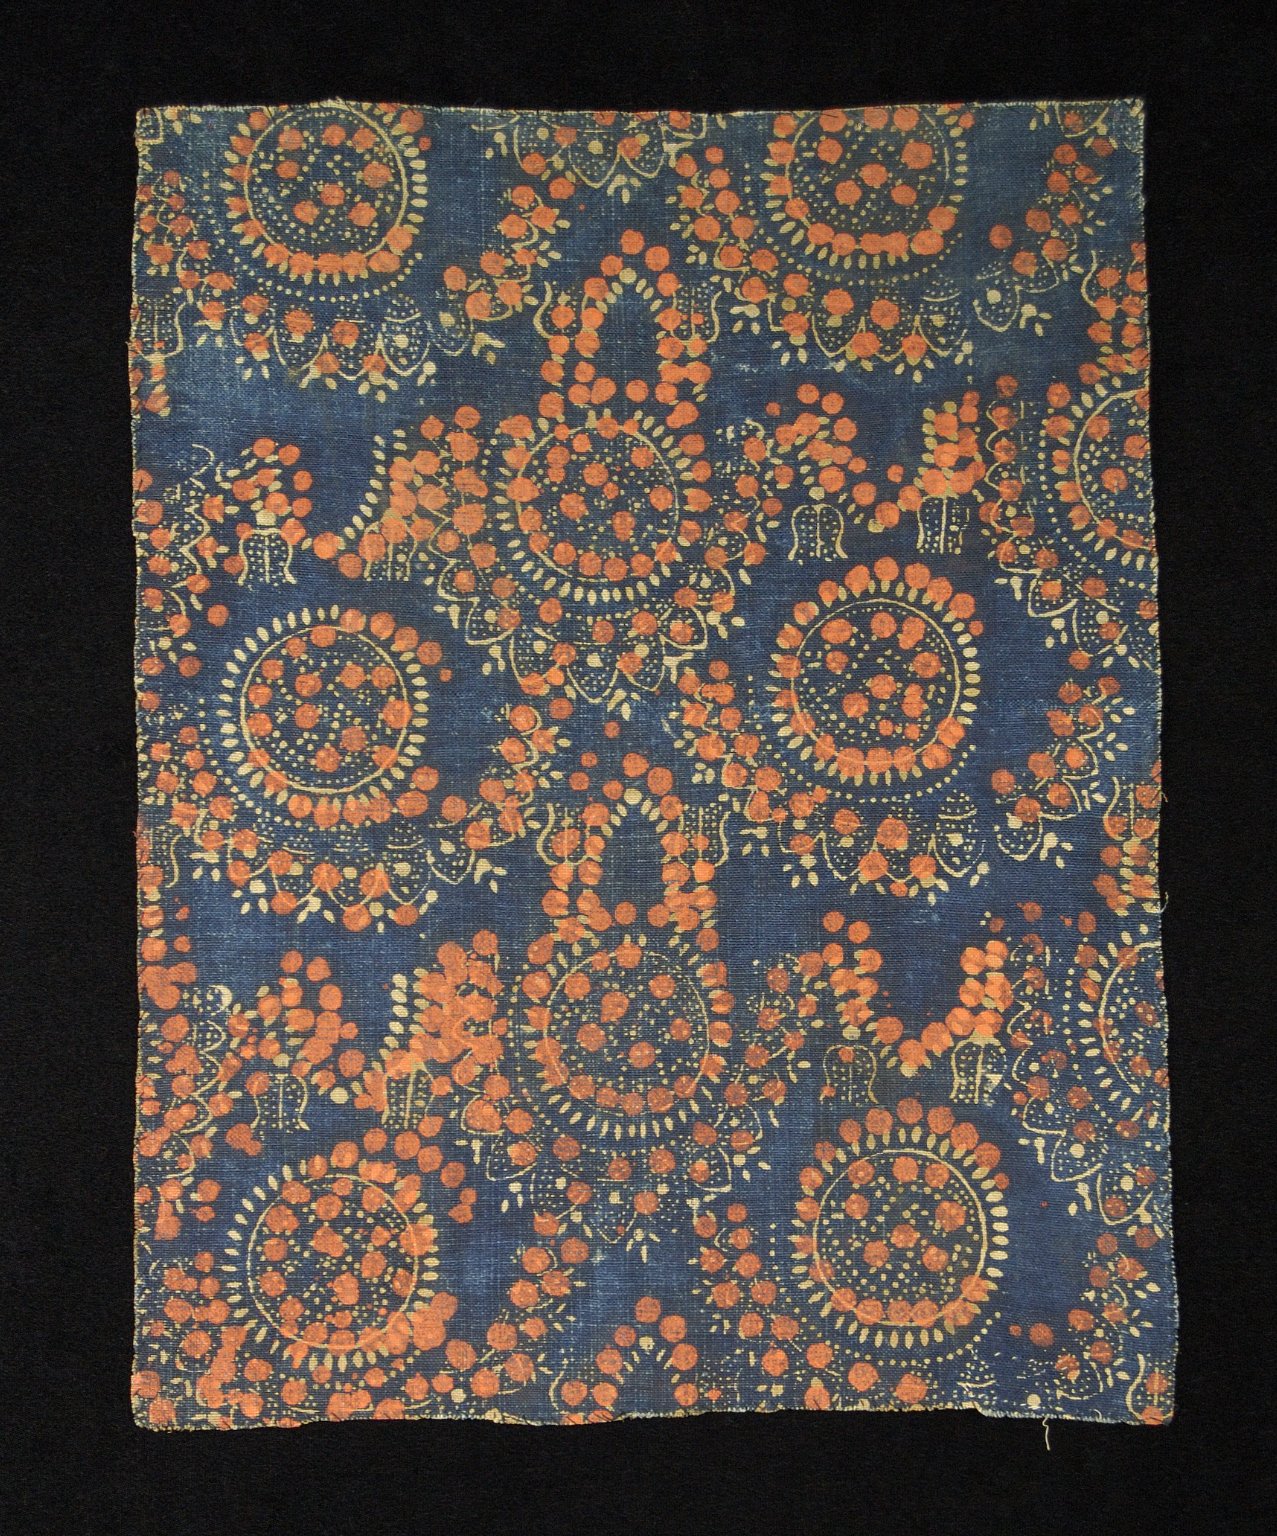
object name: textile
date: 1700-1899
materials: linen